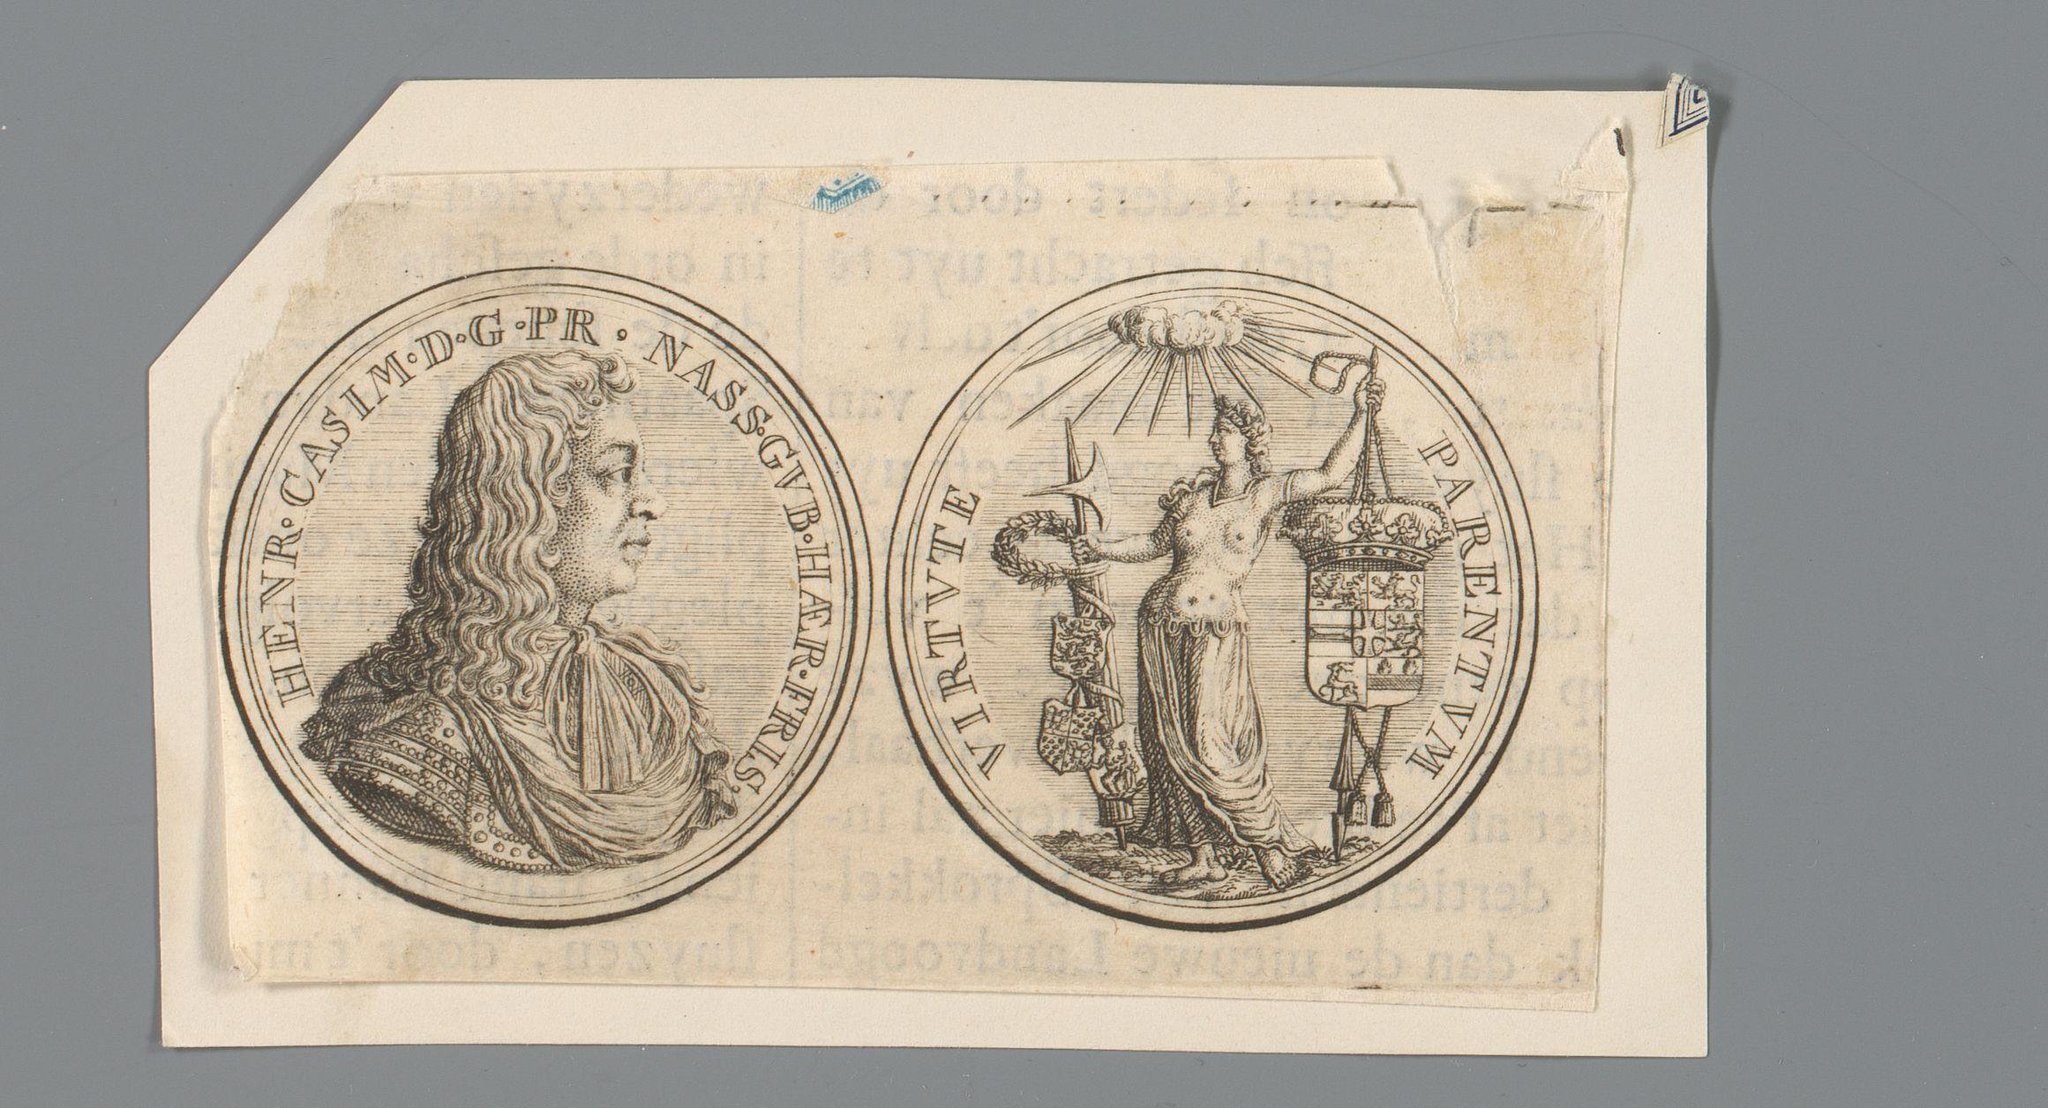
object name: book illustration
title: Voor- en achterzijde van een penning met het portret Hendrik Casimir II van Nassau-Dietz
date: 1728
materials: paper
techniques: etching, letterpress printing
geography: the hague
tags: hendrik casimir ii graaf van nassau-dietz, historical persons, coin, ranks ~ rulers, sovereigns, courage, bravery, valiance, manliness; 'ardire magnanimo et generoso', 'gagliardezza', 'valore', 'virtù heroica', 'virtù dell'animo e del corpo' (ripa)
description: Prent uit: Loon, Gerard van. Beschryving der Nederlandsche Historipenningen: (...). Den Haag: Christiaan van Lom et al., 1728, dl. 3, p. 176.